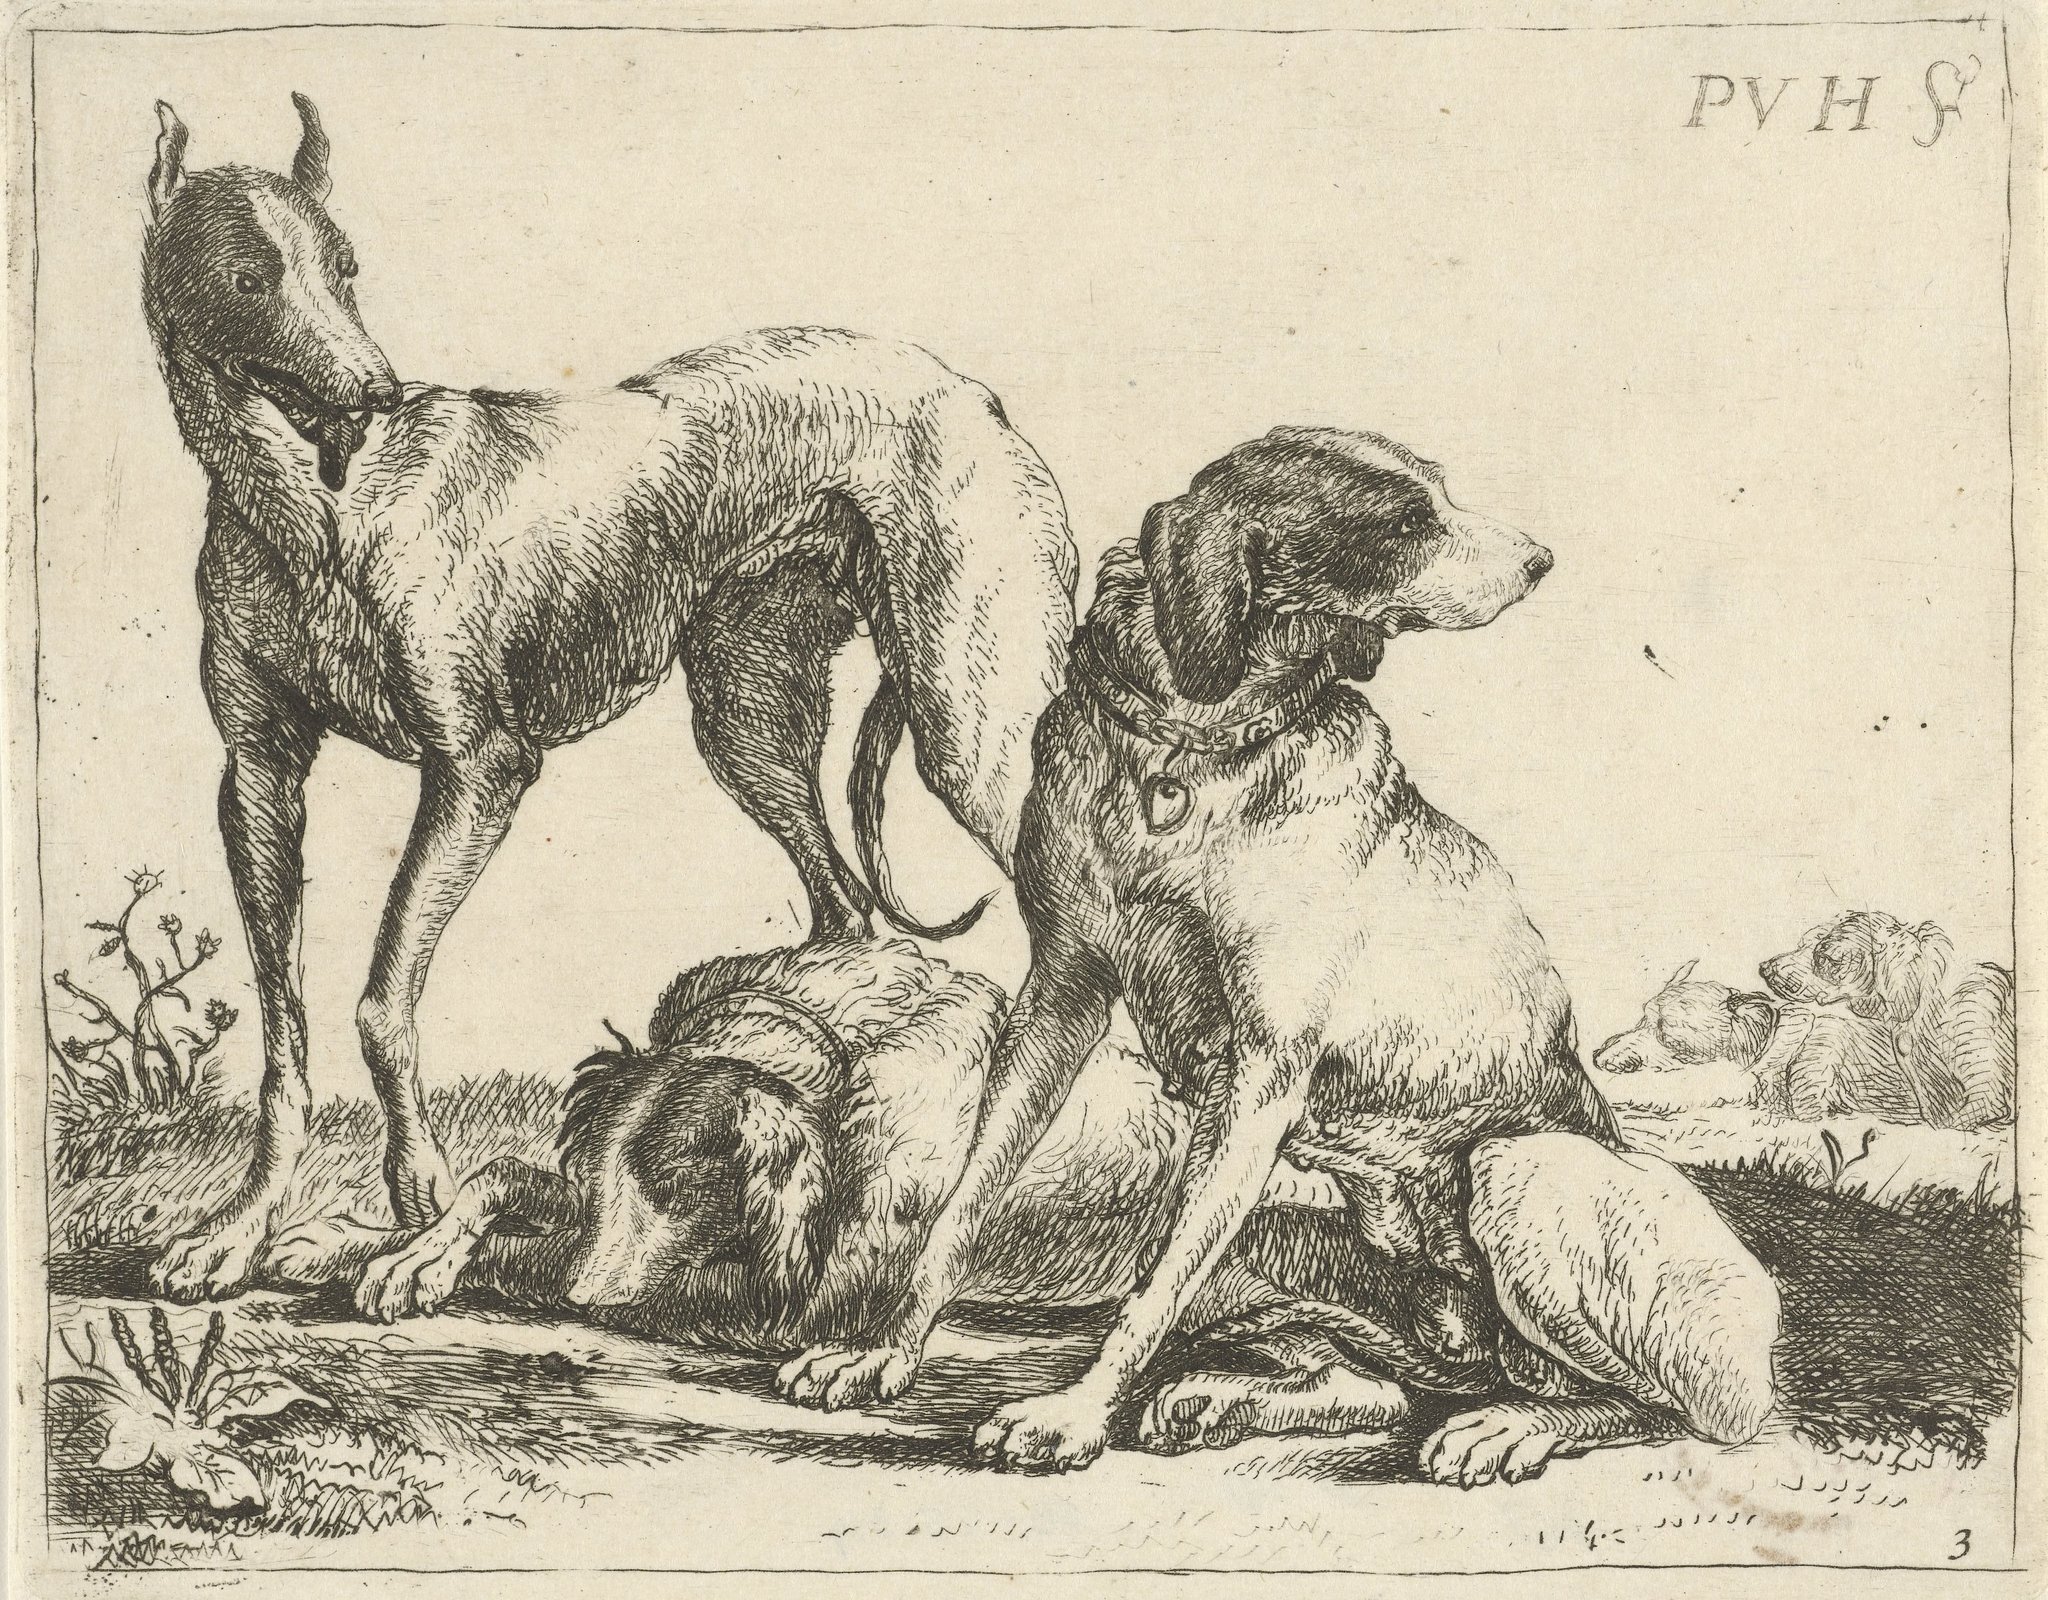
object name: print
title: Verschillende honden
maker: pauwels van hillegaert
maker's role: painter, print maker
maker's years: 1596-1658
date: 1606-1658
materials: paper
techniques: etching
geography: amsterdam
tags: dog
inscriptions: collector's mark: Lugt 240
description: Drie honden in een landschap. Op de achtergrond nog twee honden. Tweede prent van een serie van vier prenten met voorstellingen van honden.